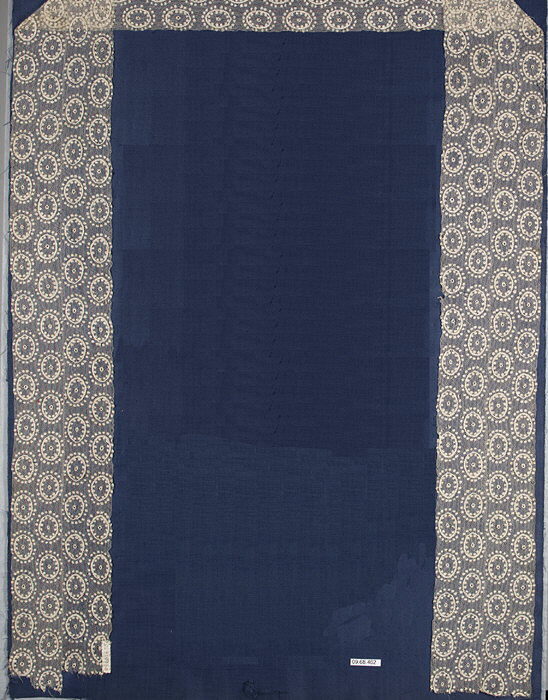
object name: fragment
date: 1801-1900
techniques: lace